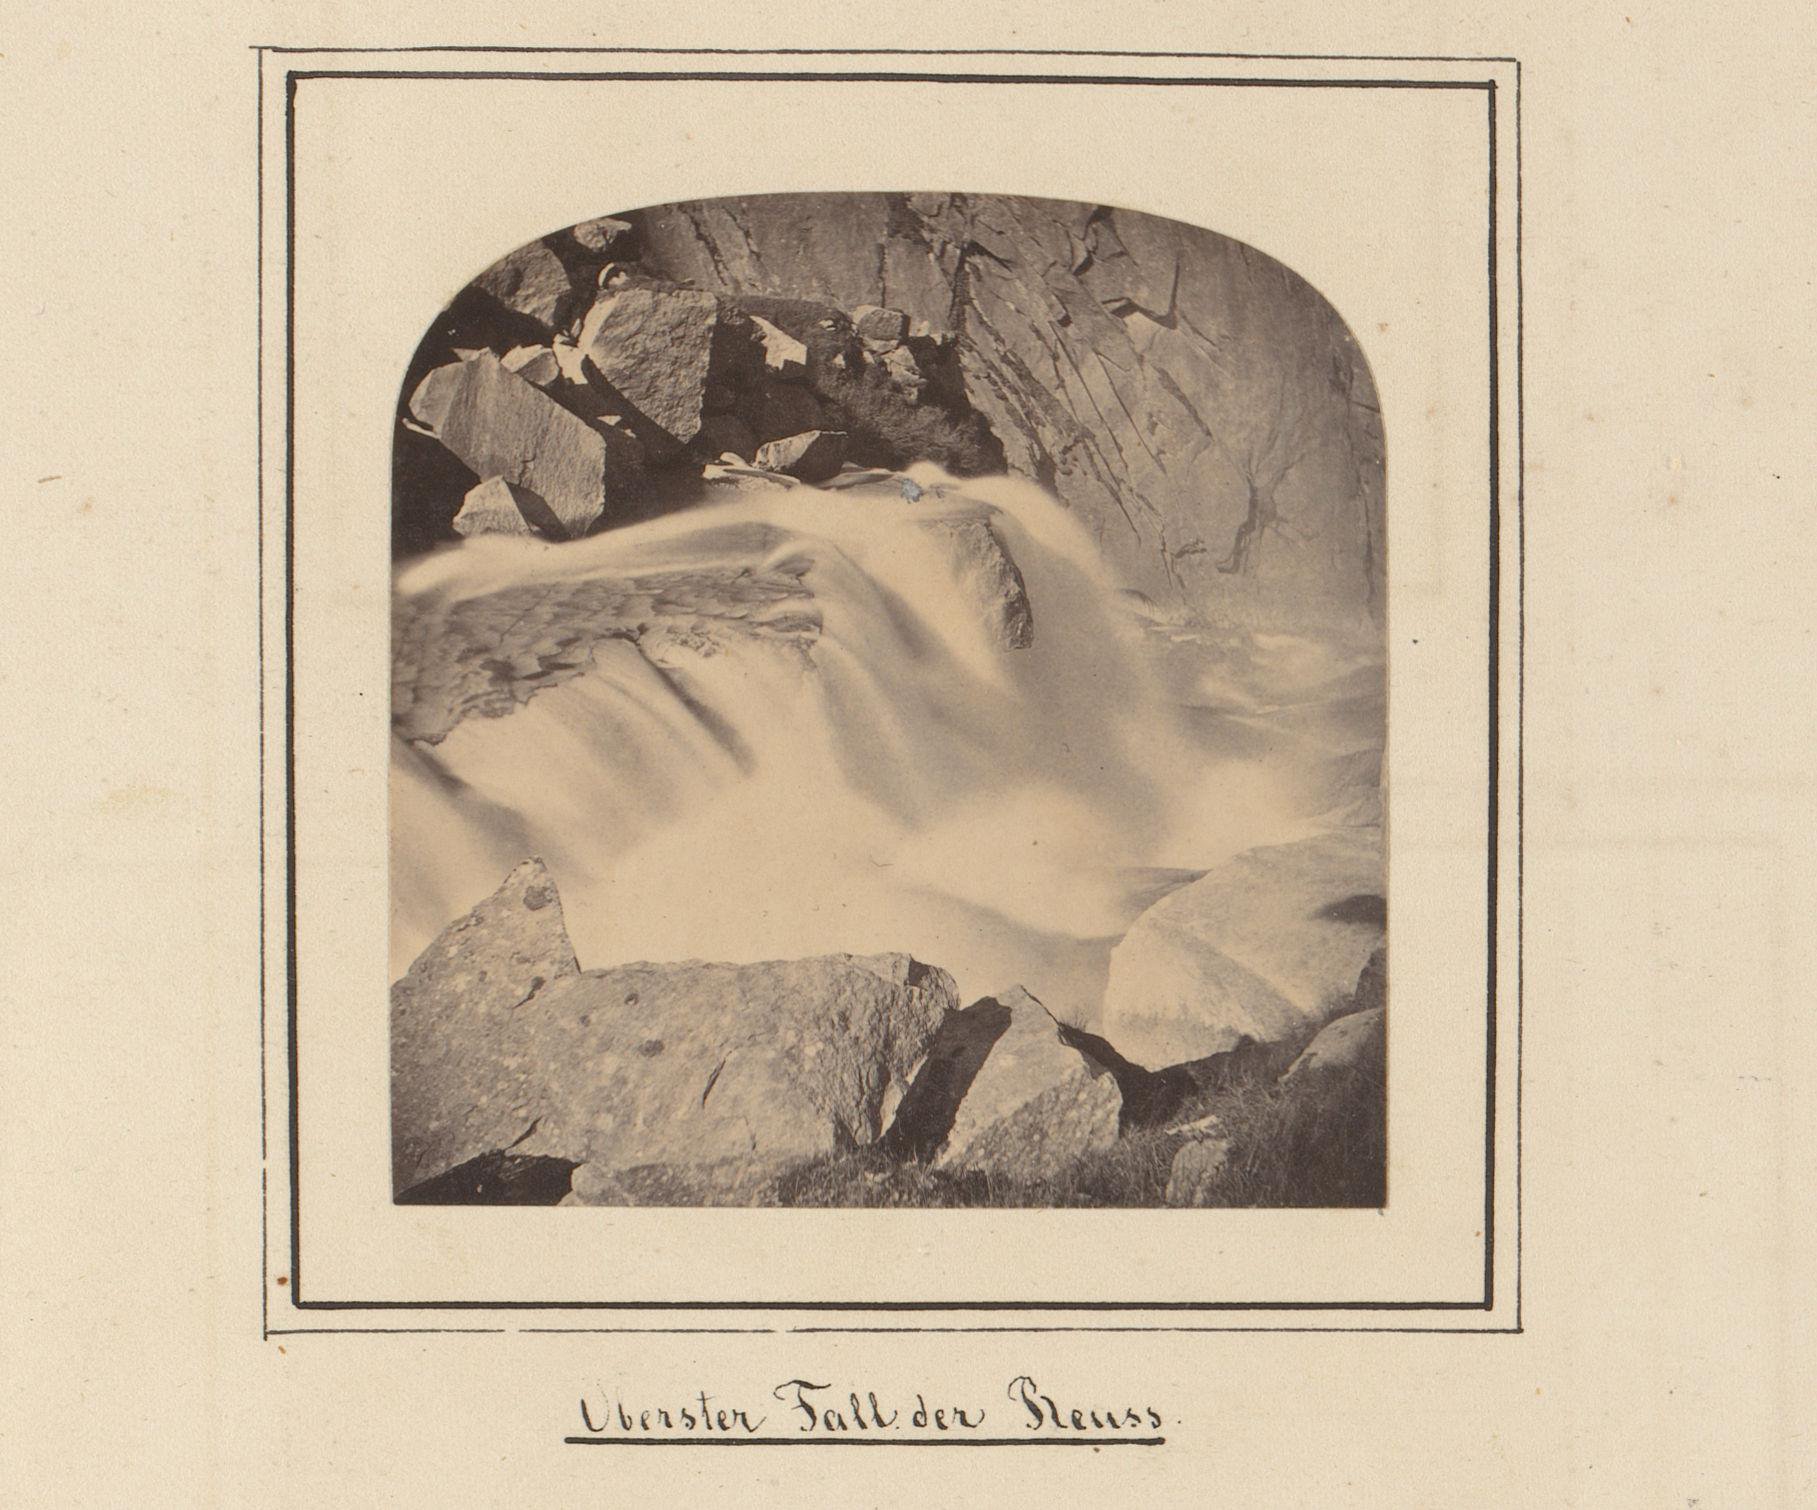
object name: photograph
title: Oberster Fall der Reuss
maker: Anonymous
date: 1870-1890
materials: paper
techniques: albumen print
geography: reuss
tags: waterfall